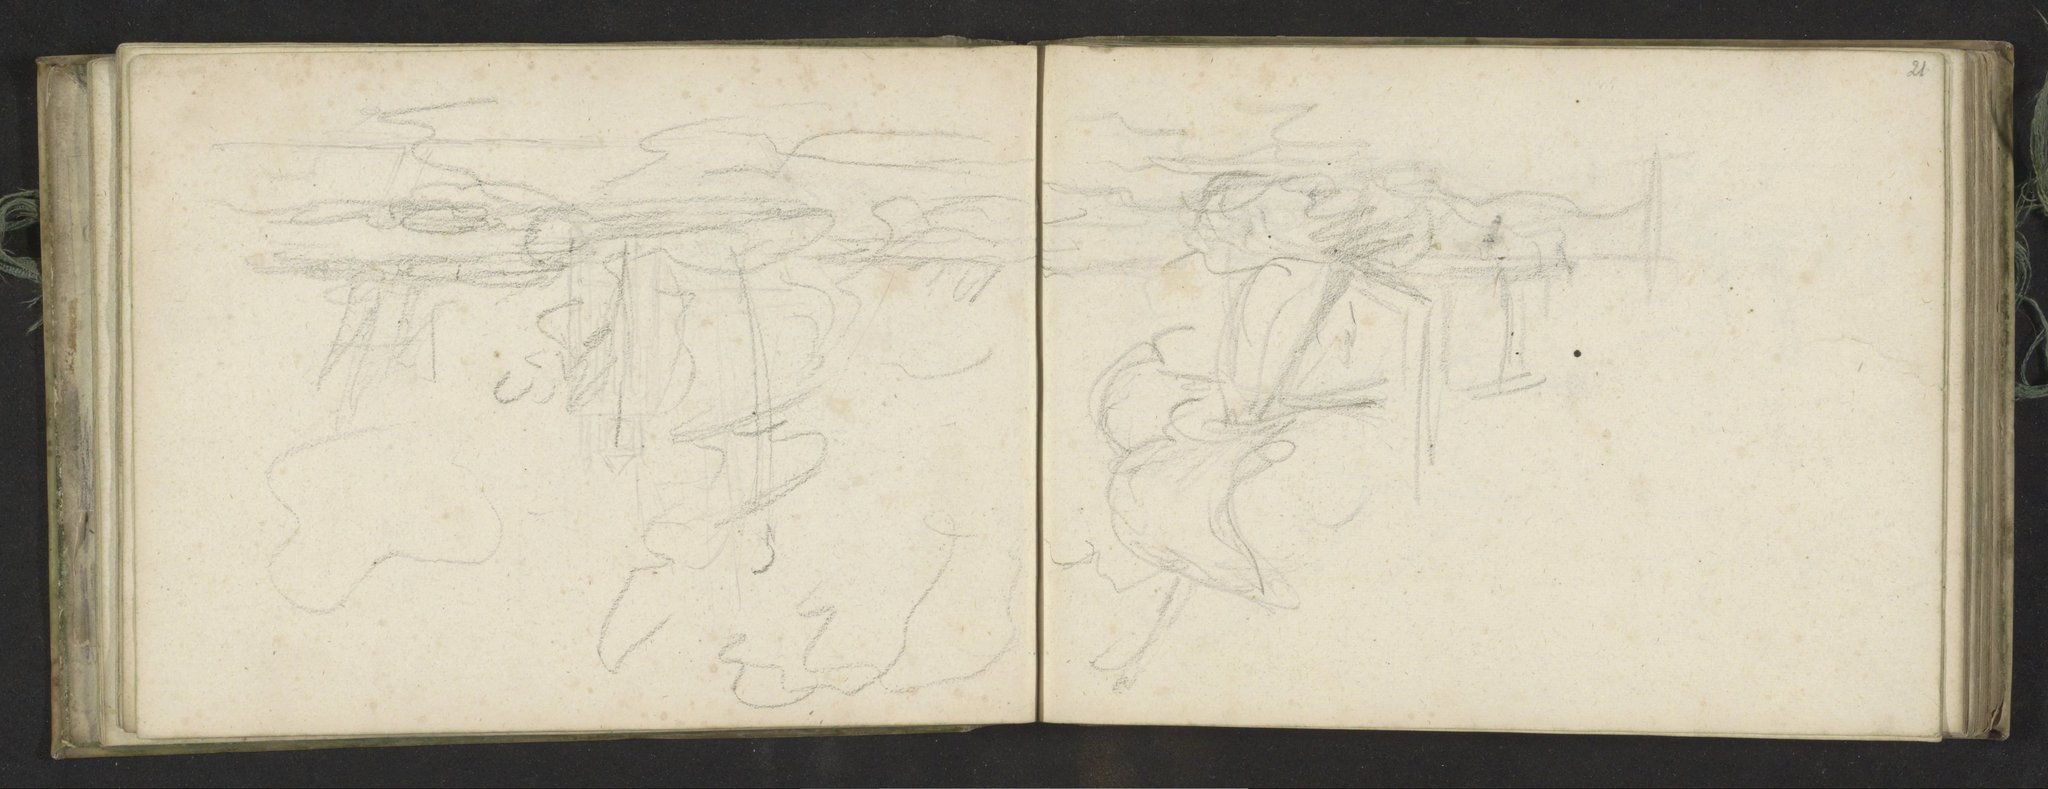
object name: sketchbook leaf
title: Zeilschepen op het water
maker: martinus schouman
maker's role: draughtsman, painter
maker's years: 1770-1848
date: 1780-1848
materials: paper, pencil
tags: sailing-ship, sailing-boat, landscapes with waters, waterscapes, seascapes (in the temperate zone)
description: Blad 20 verso en 21 recto uit een schetsboek met 53 bladen.